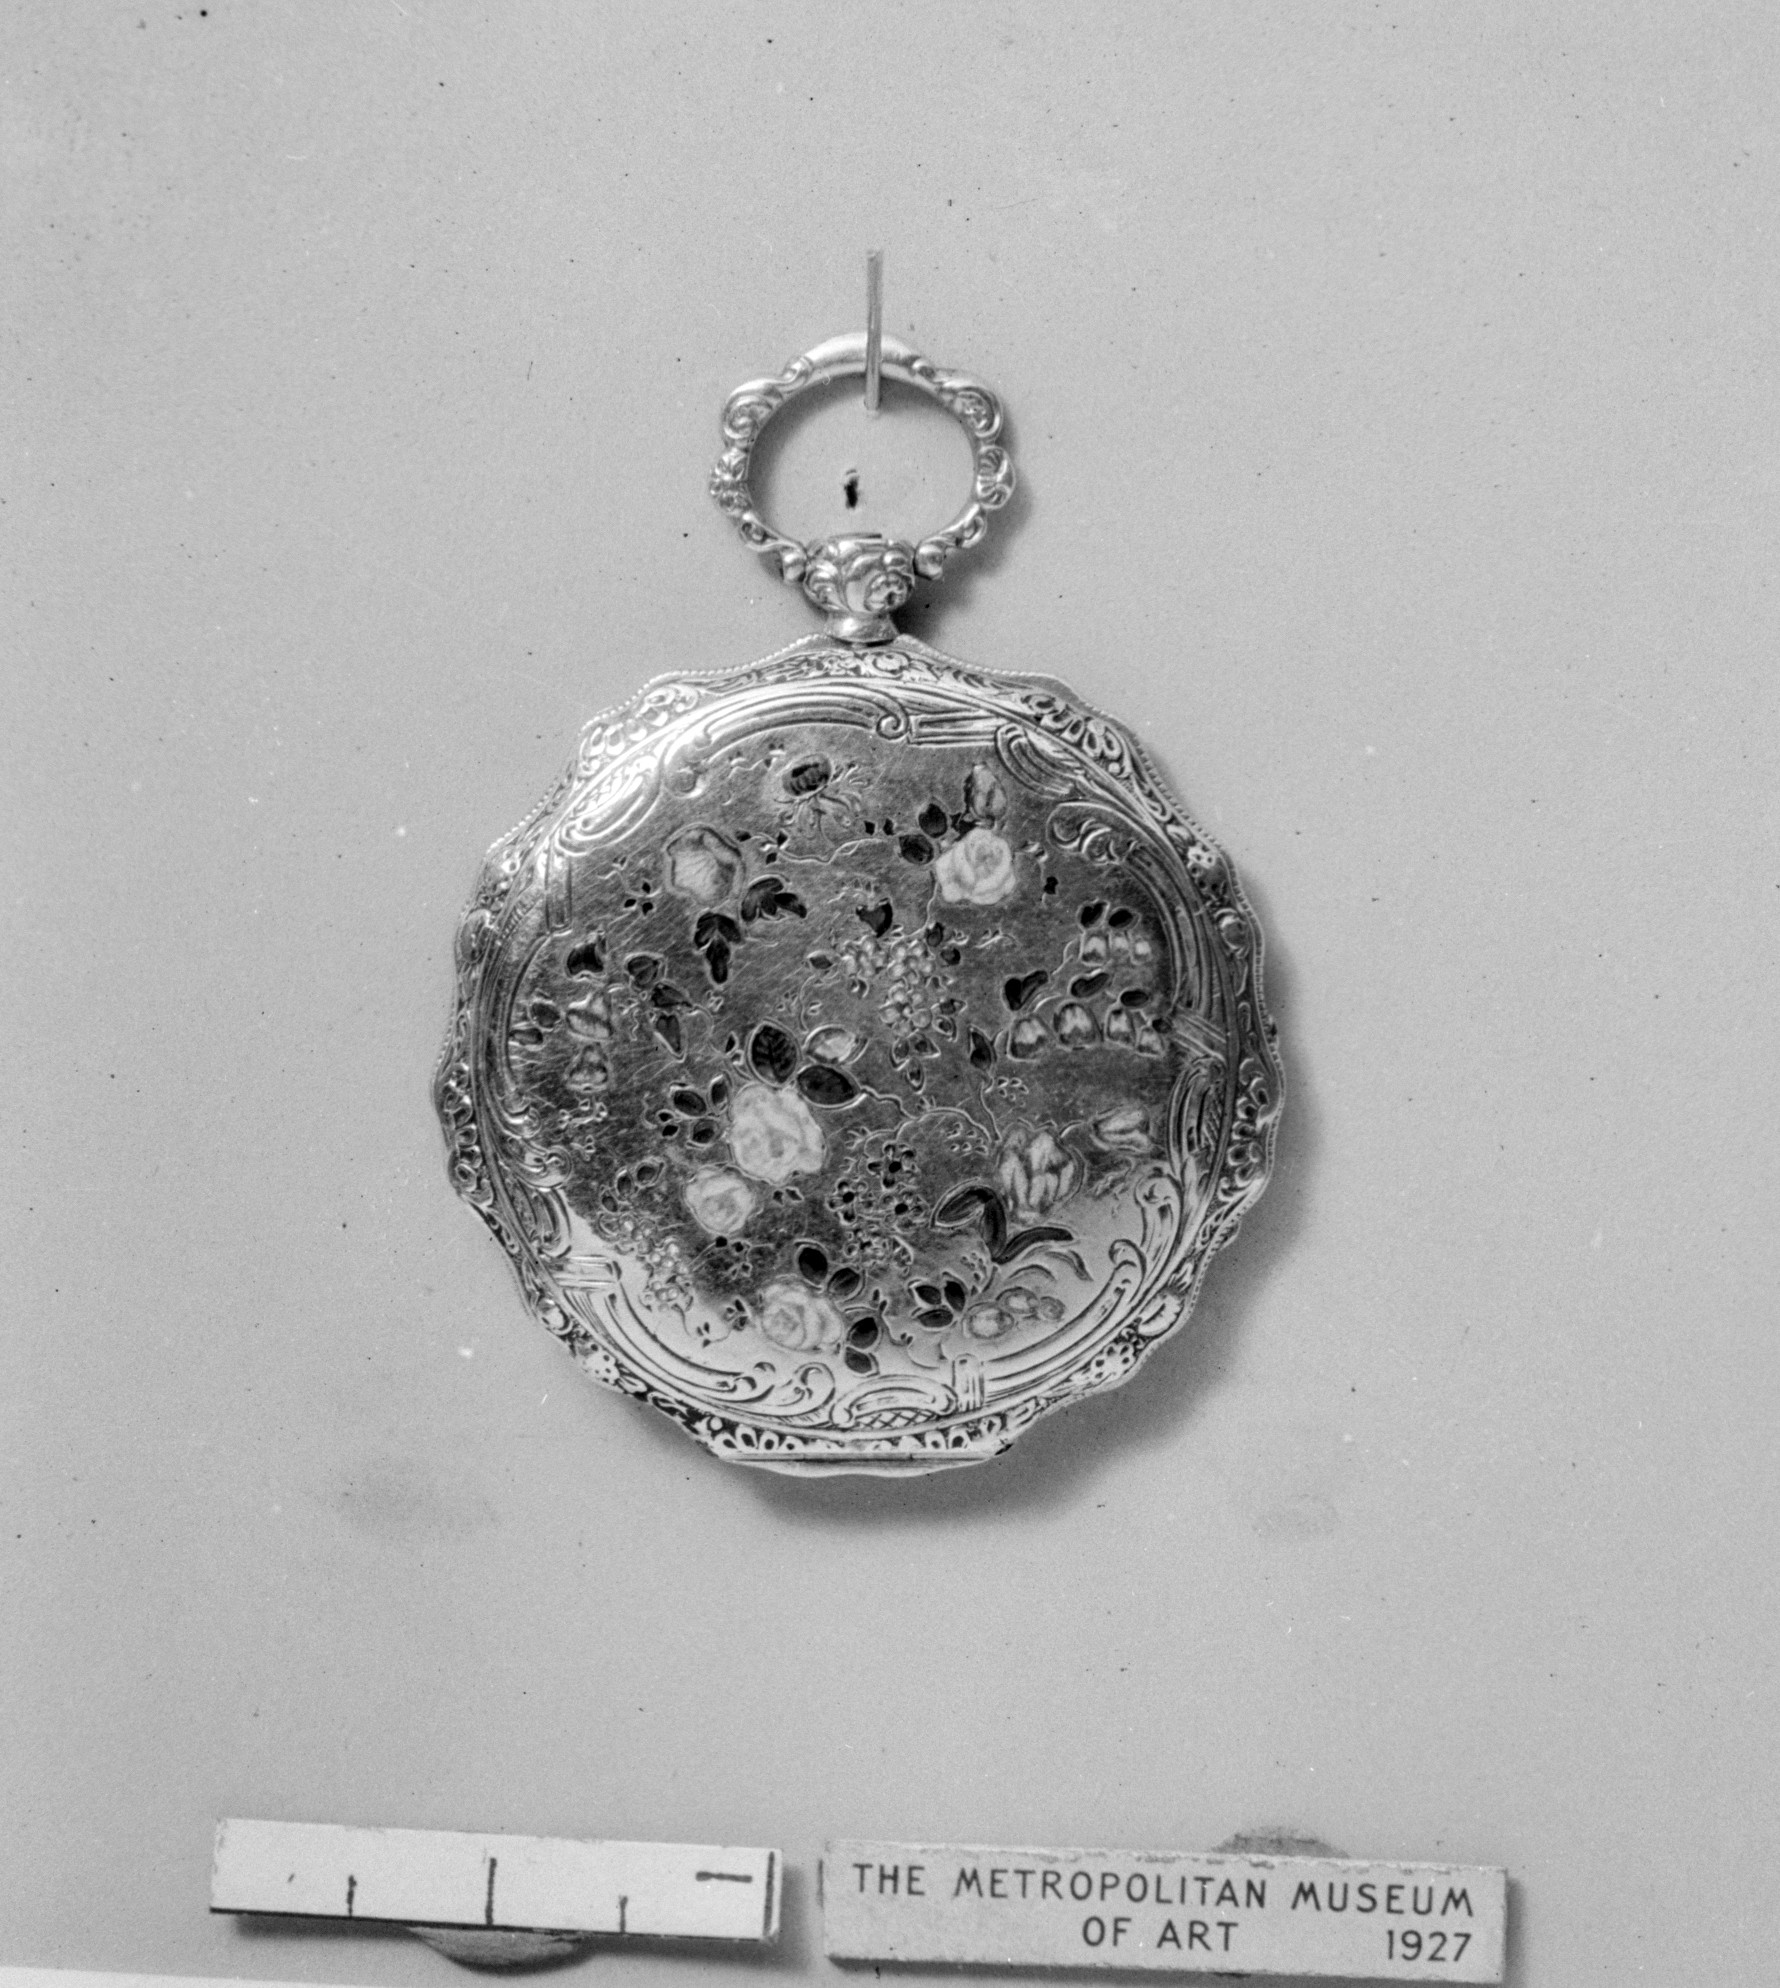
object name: watch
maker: firm of blondel & melly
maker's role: maker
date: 1840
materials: enamel, gold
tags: roses,leaves